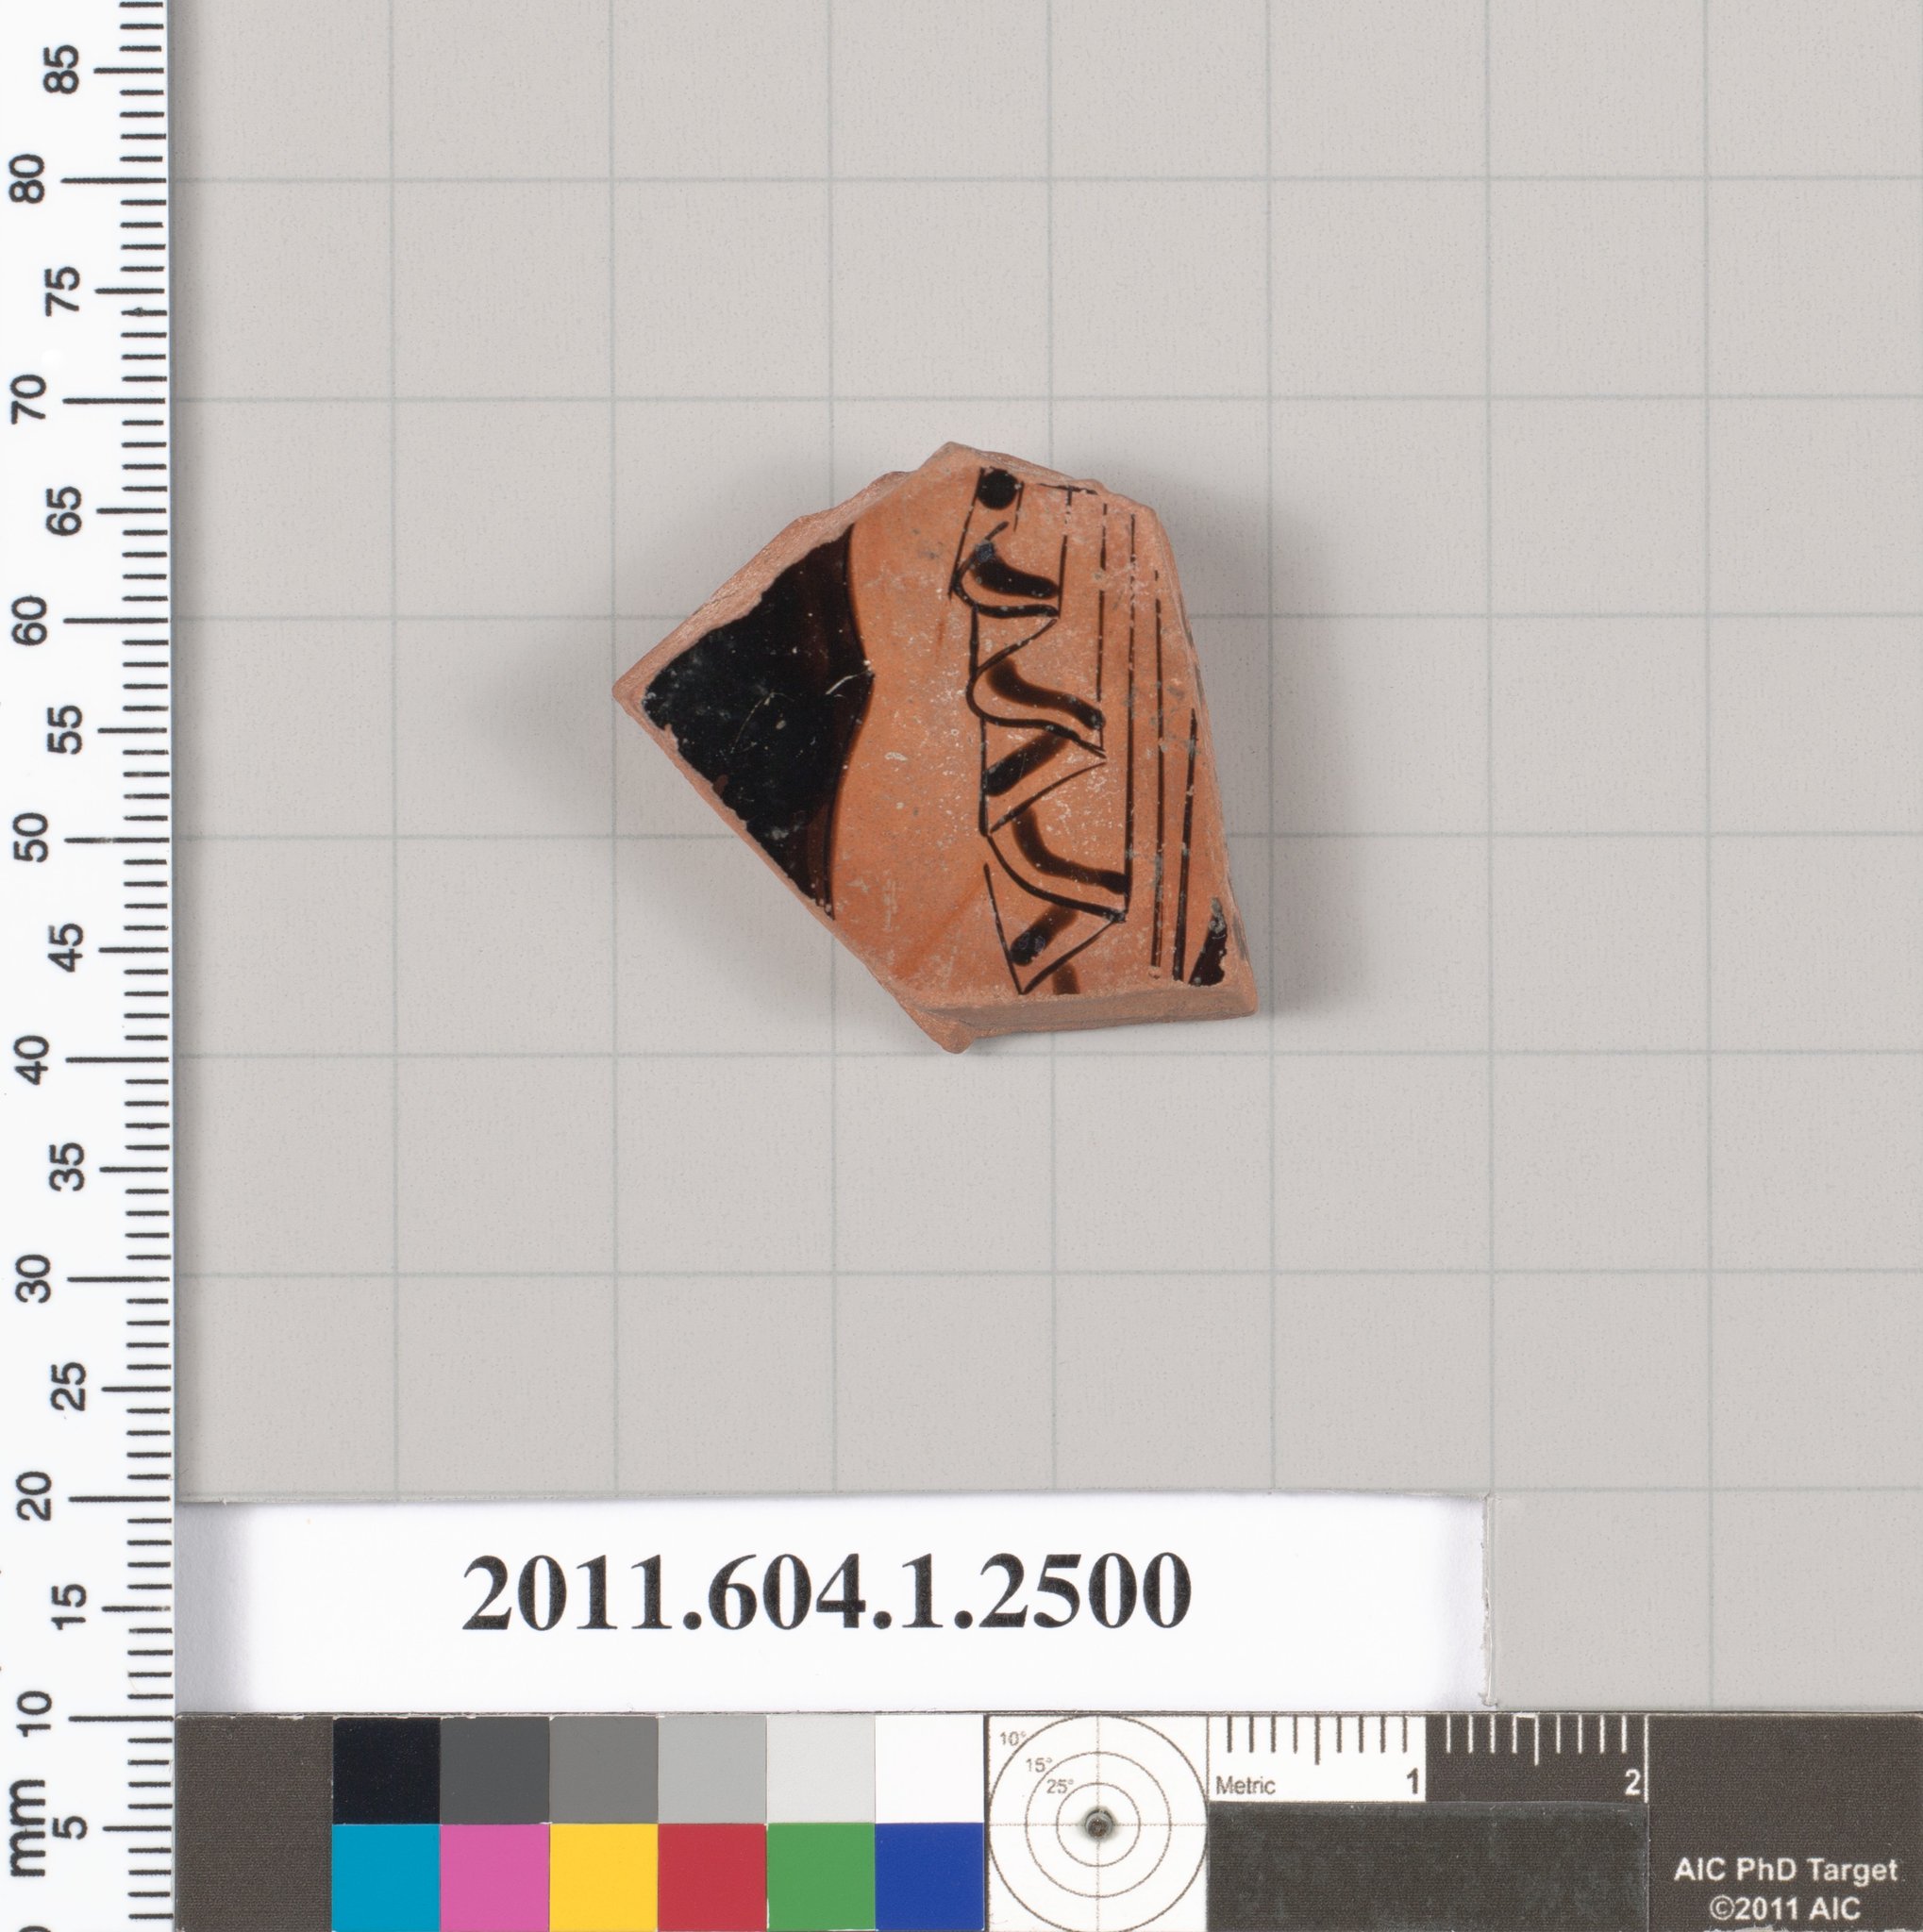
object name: kylix fragment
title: Terracotta fragment of a kylix (drinking cup)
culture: greek, attic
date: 490-480 BCE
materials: terracotta